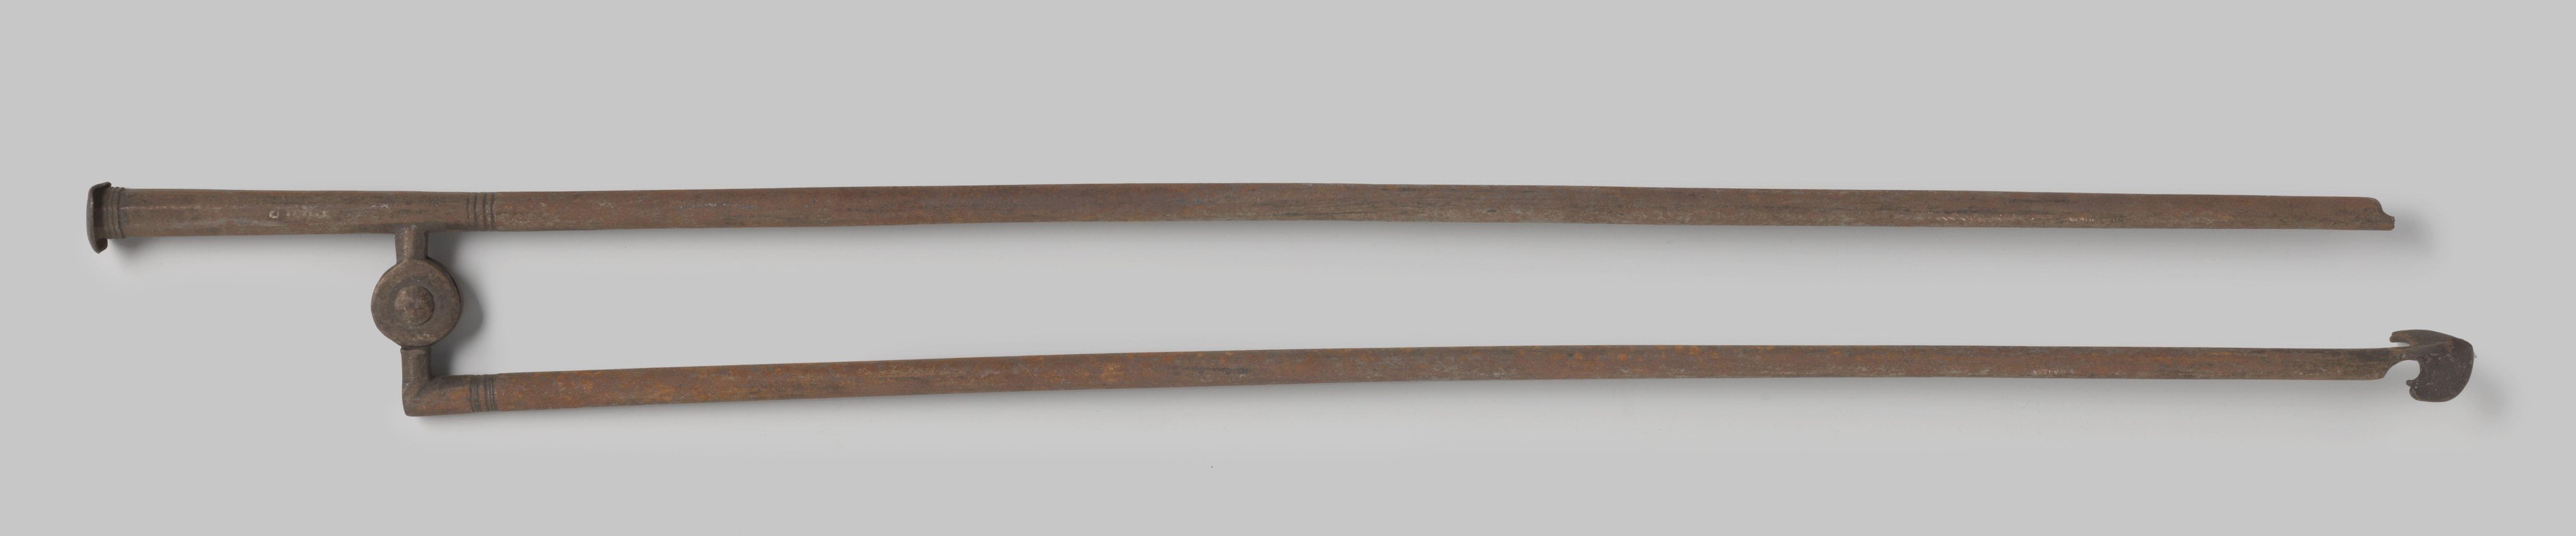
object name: tang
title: Tang en blaaspijp ineen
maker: Anonymous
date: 1400-1950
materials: iron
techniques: forging